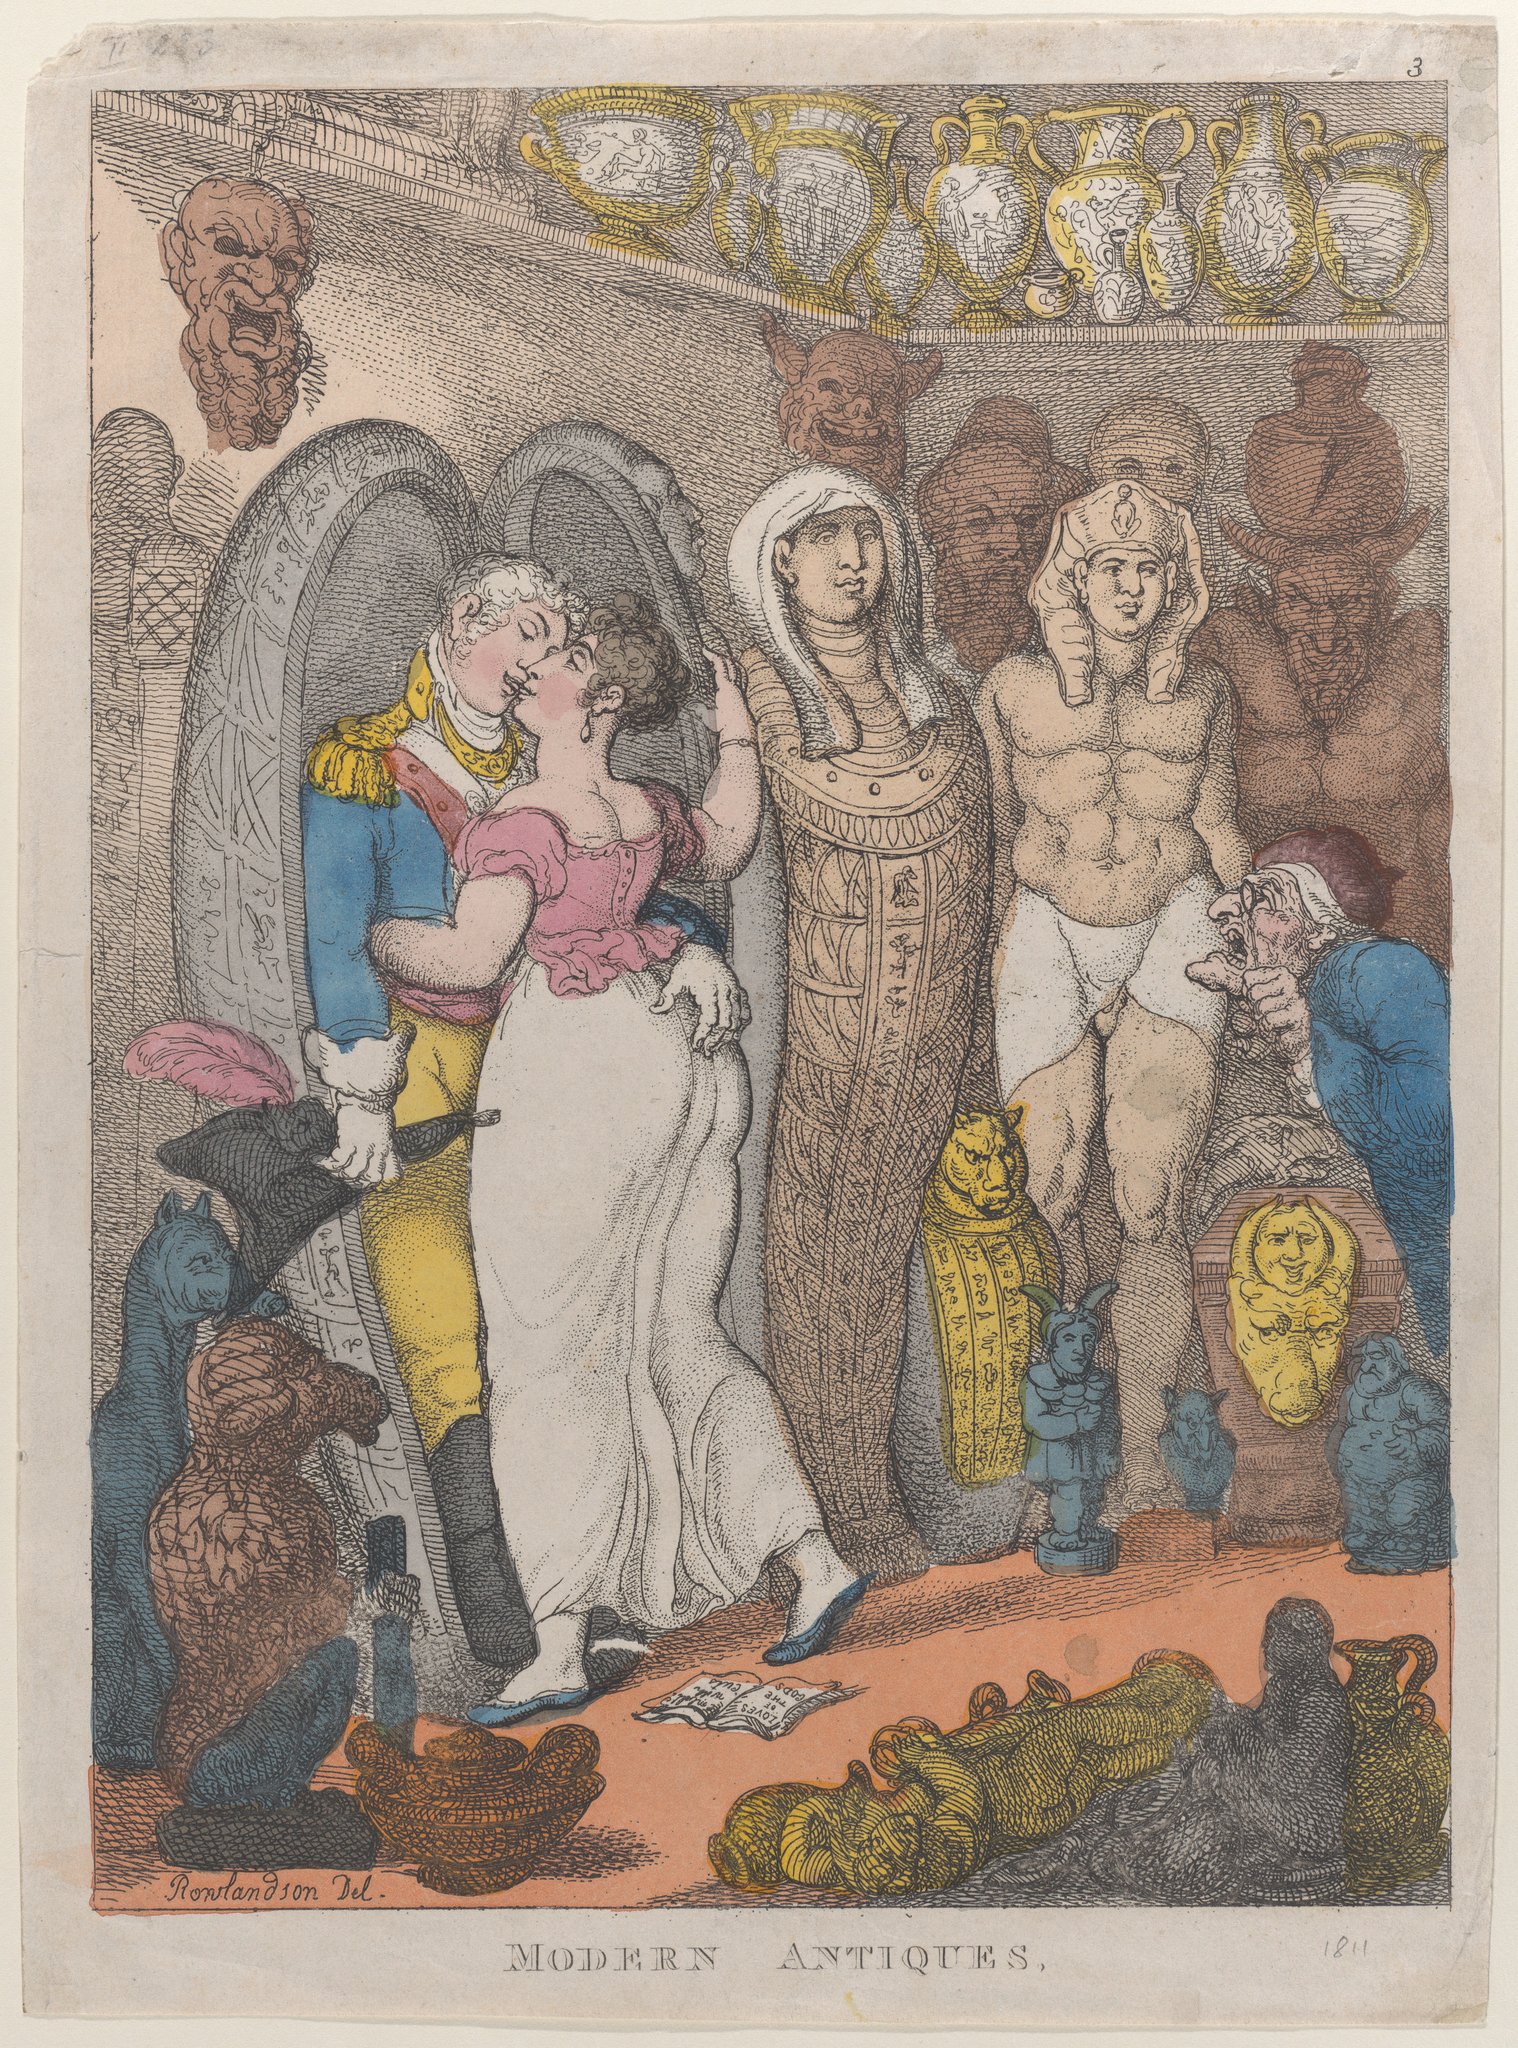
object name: print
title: Modern Antiquities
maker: thomas rowlandson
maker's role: artist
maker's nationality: british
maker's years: 1757-1827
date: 1811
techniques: etching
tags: satire,men,women